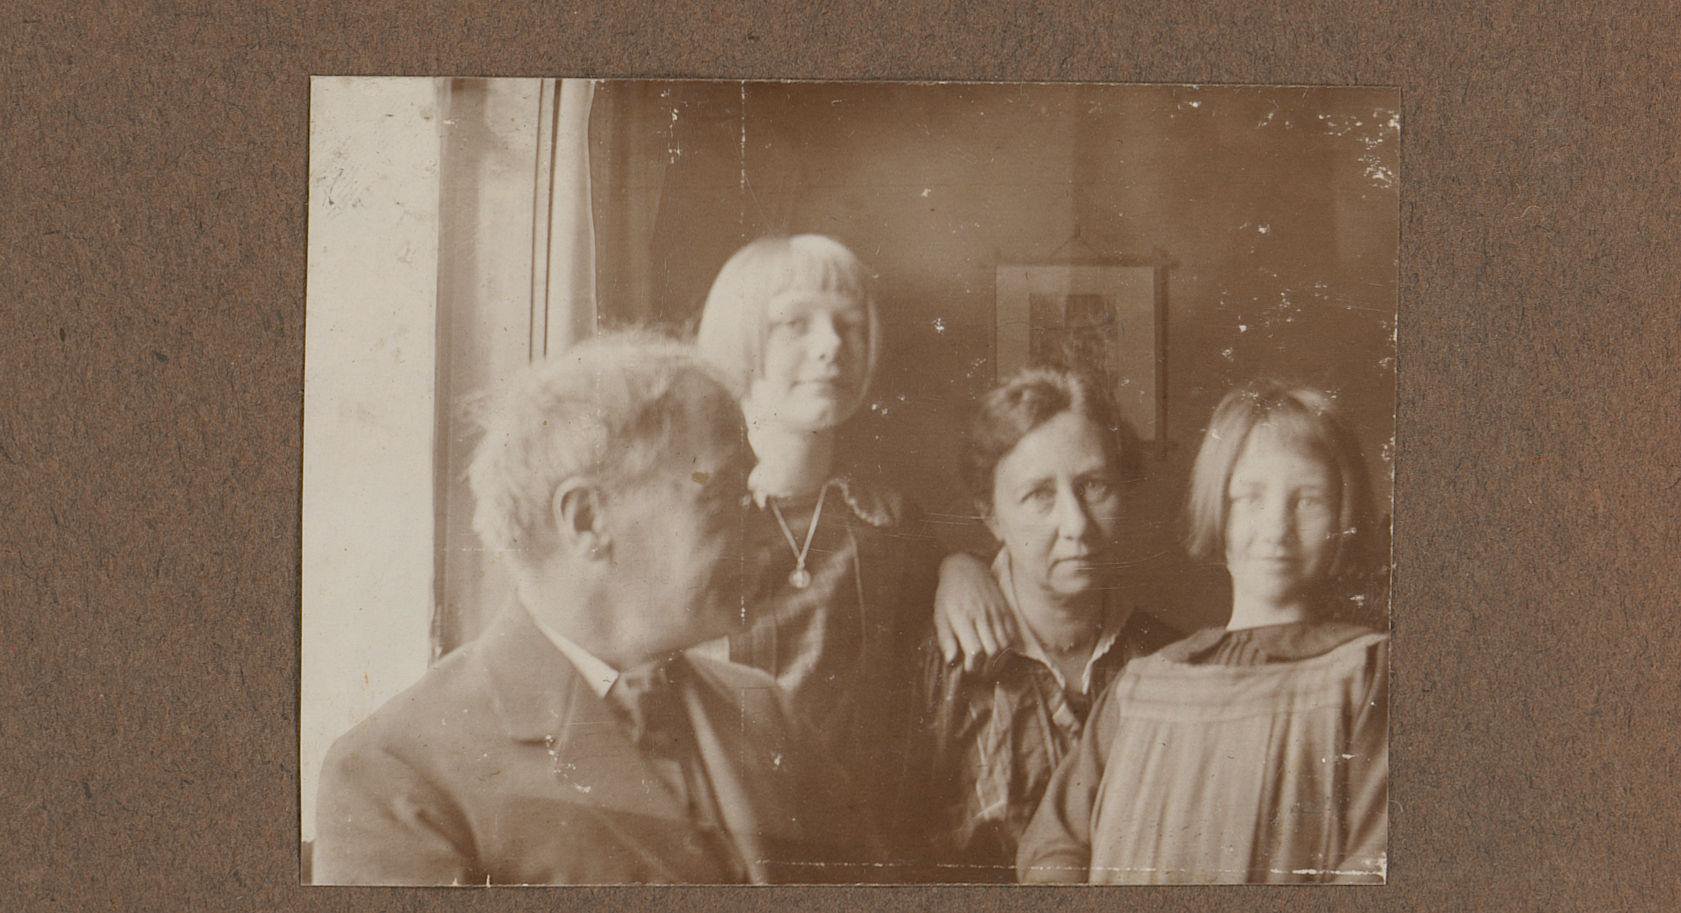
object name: photograph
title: Het gezin van Alphons Diepenbrock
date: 1908-1915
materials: photographic support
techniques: photography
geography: netherlands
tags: amsterdam, alphons diepenbrock, jonkvrouw wilhelmina elisabeth petronella cornelia de jong van beek en donk, netherlands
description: Foto op bruin albumblad 49 van familiealbum van Alphons Diepenbrock.